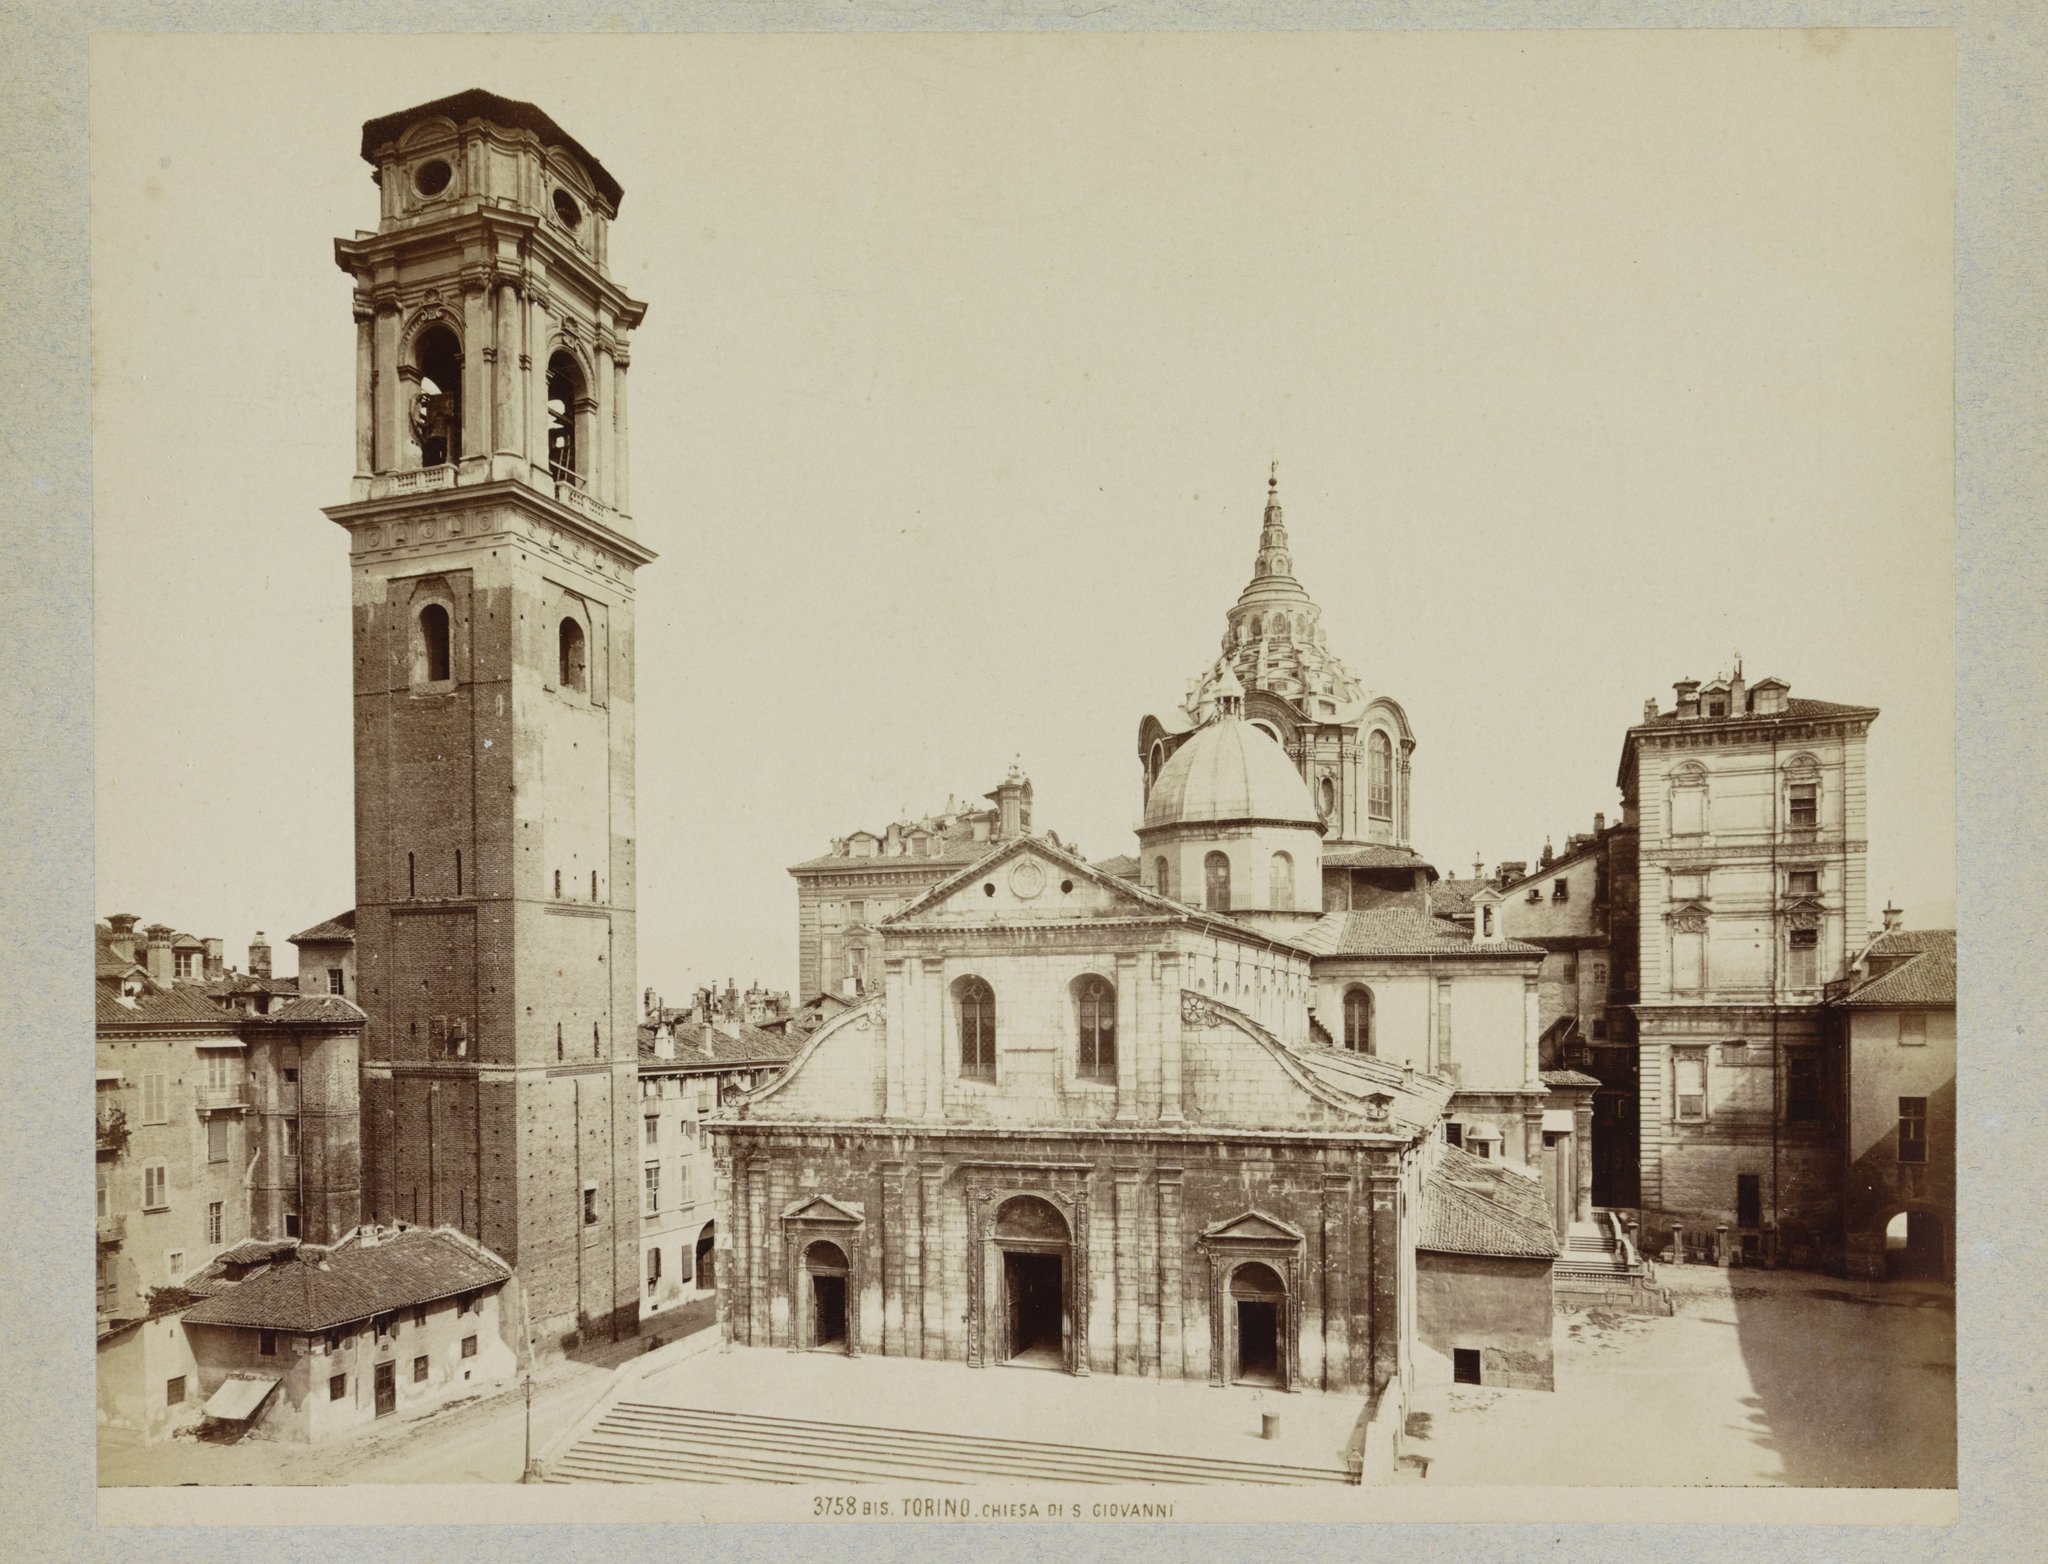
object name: photograph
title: Chiesa di S. Giovanni Battista aan het Piazza S. Giovanni, Turijn (Torino), Italië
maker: Anonymous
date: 1885-1900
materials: paper, photographic support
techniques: albumen print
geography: turin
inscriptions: caption: ‘3758 bis Torino Chiesa di S. Giovanni’